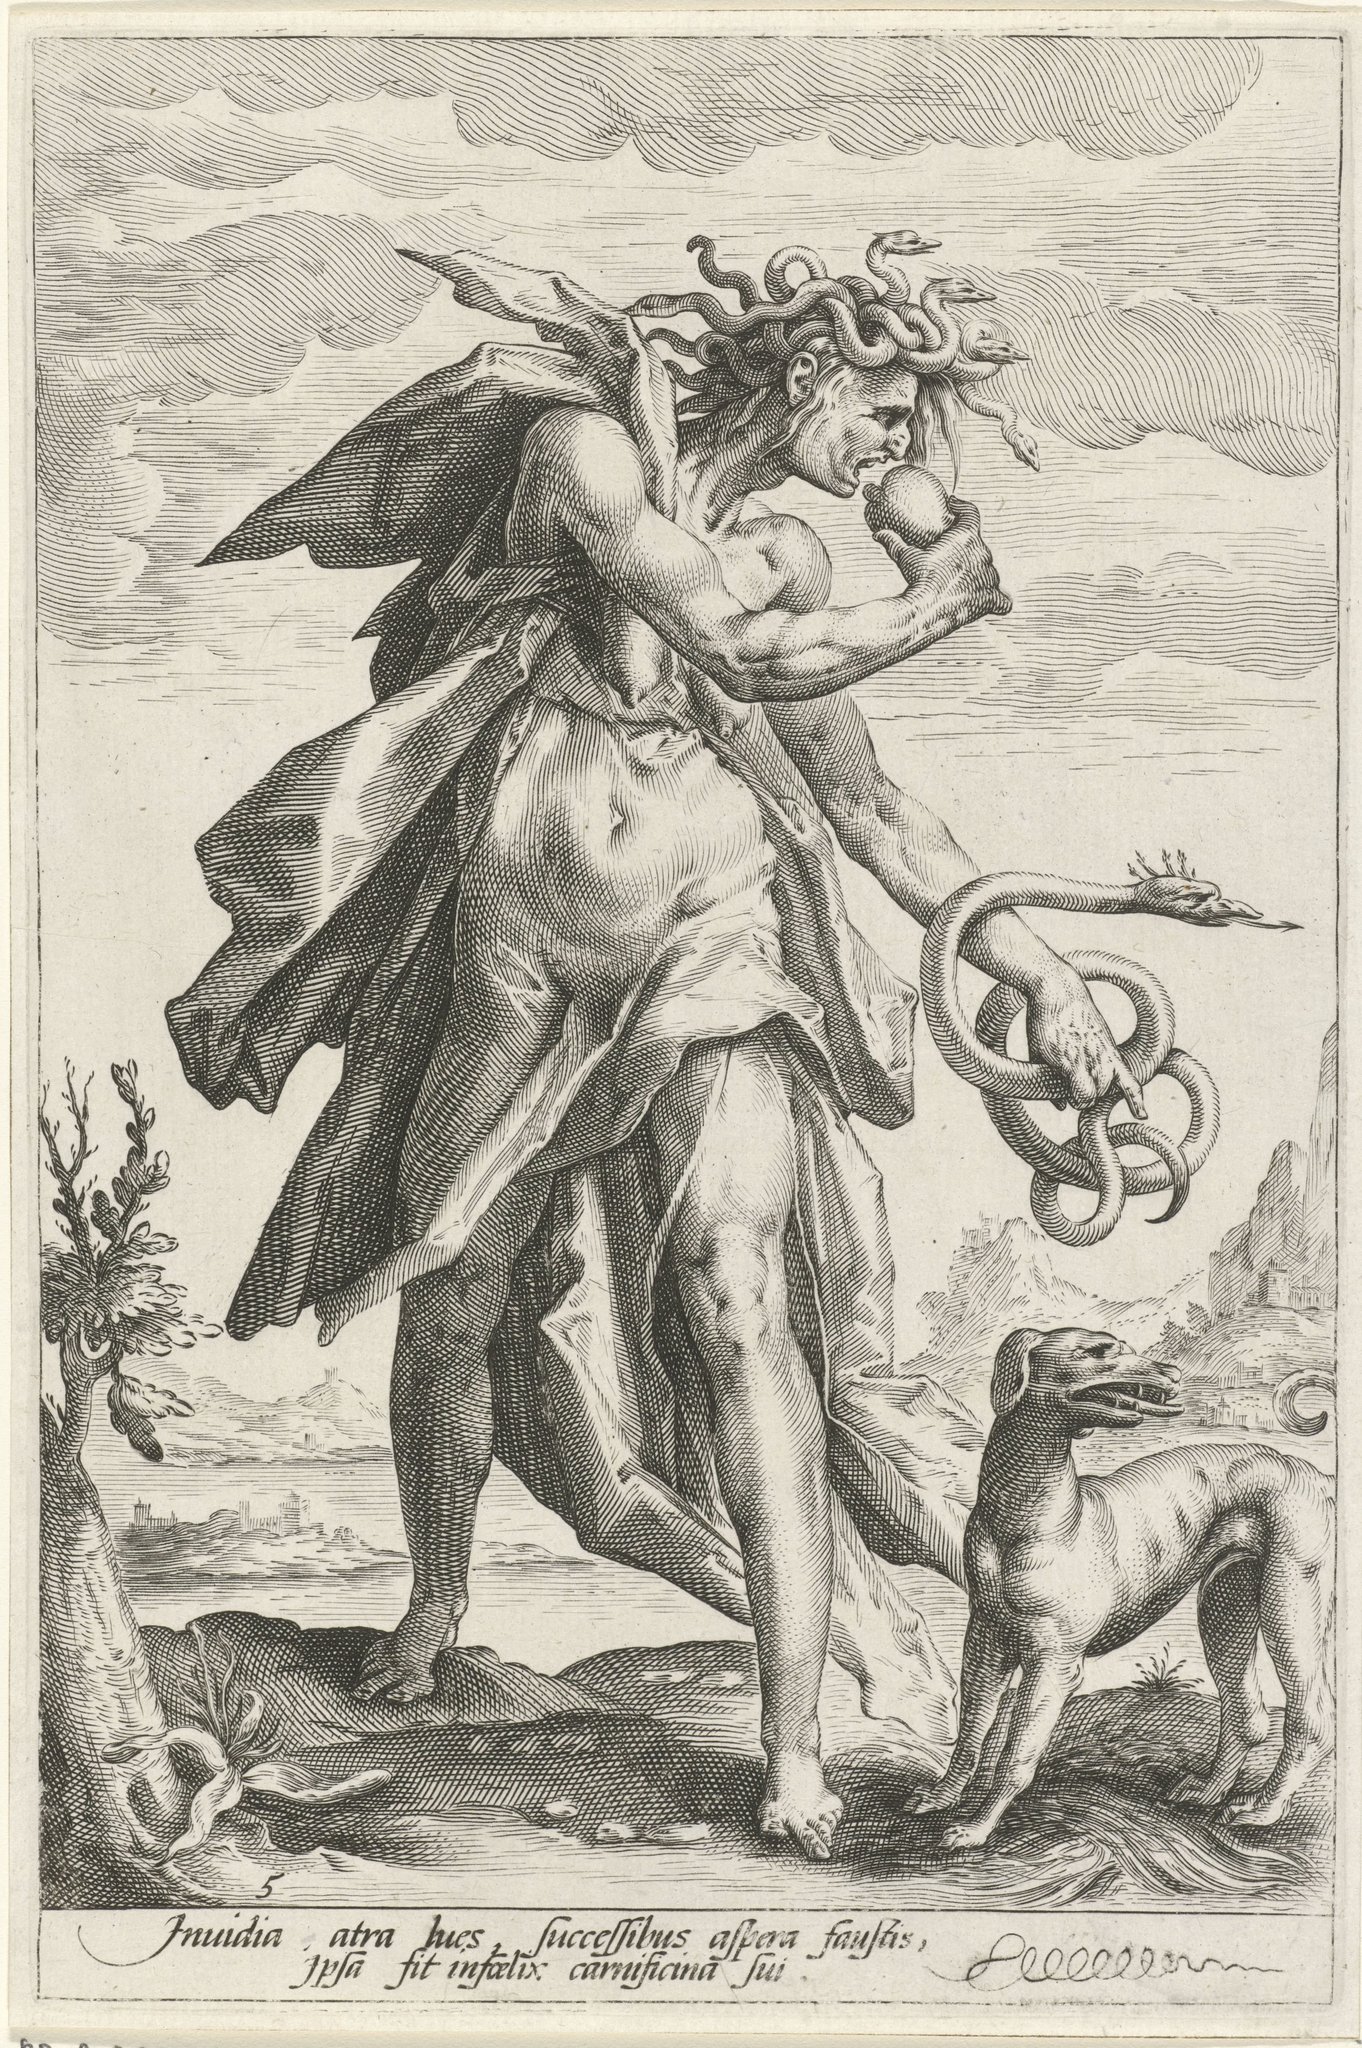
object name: print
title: Afgunst (Invidia)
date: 1585-1589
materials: paper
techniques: engraving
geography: haarlem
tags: envy; 'invidia' (ripa) ~ personification of one of the seven deadly sins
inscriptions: collector's mark: Lugt 240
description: De gepersonifieerde Afgunst; een oude vrouwenfiguur met slangen als haar, knagend op een hart en met een slang in haar hand. Naast haar een hond.